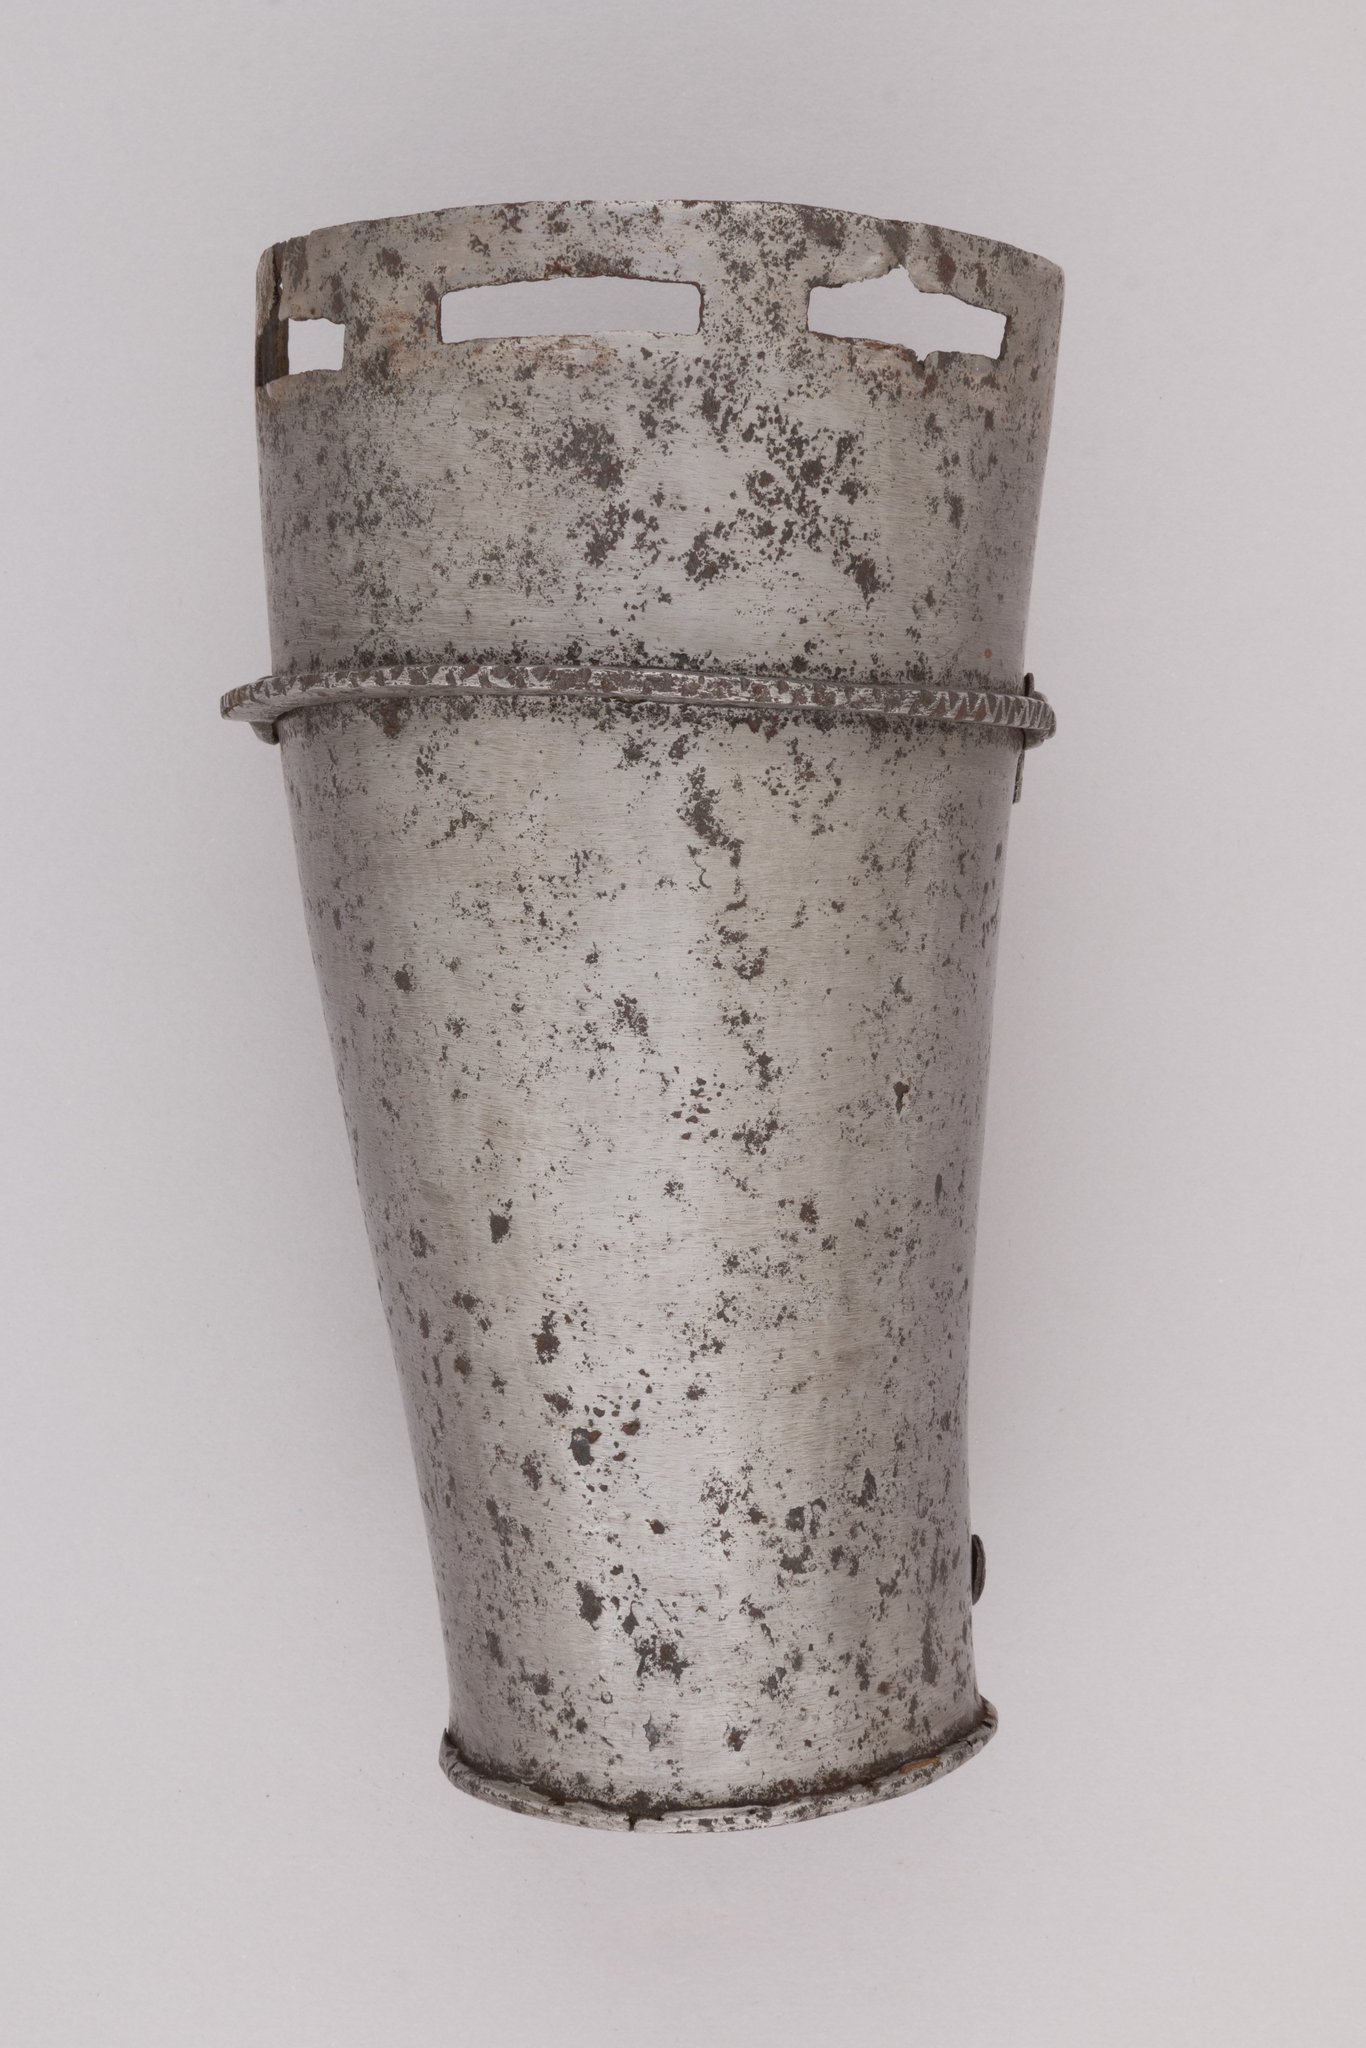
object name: arm defense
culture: italian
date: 1401-1500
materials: steel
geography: italy